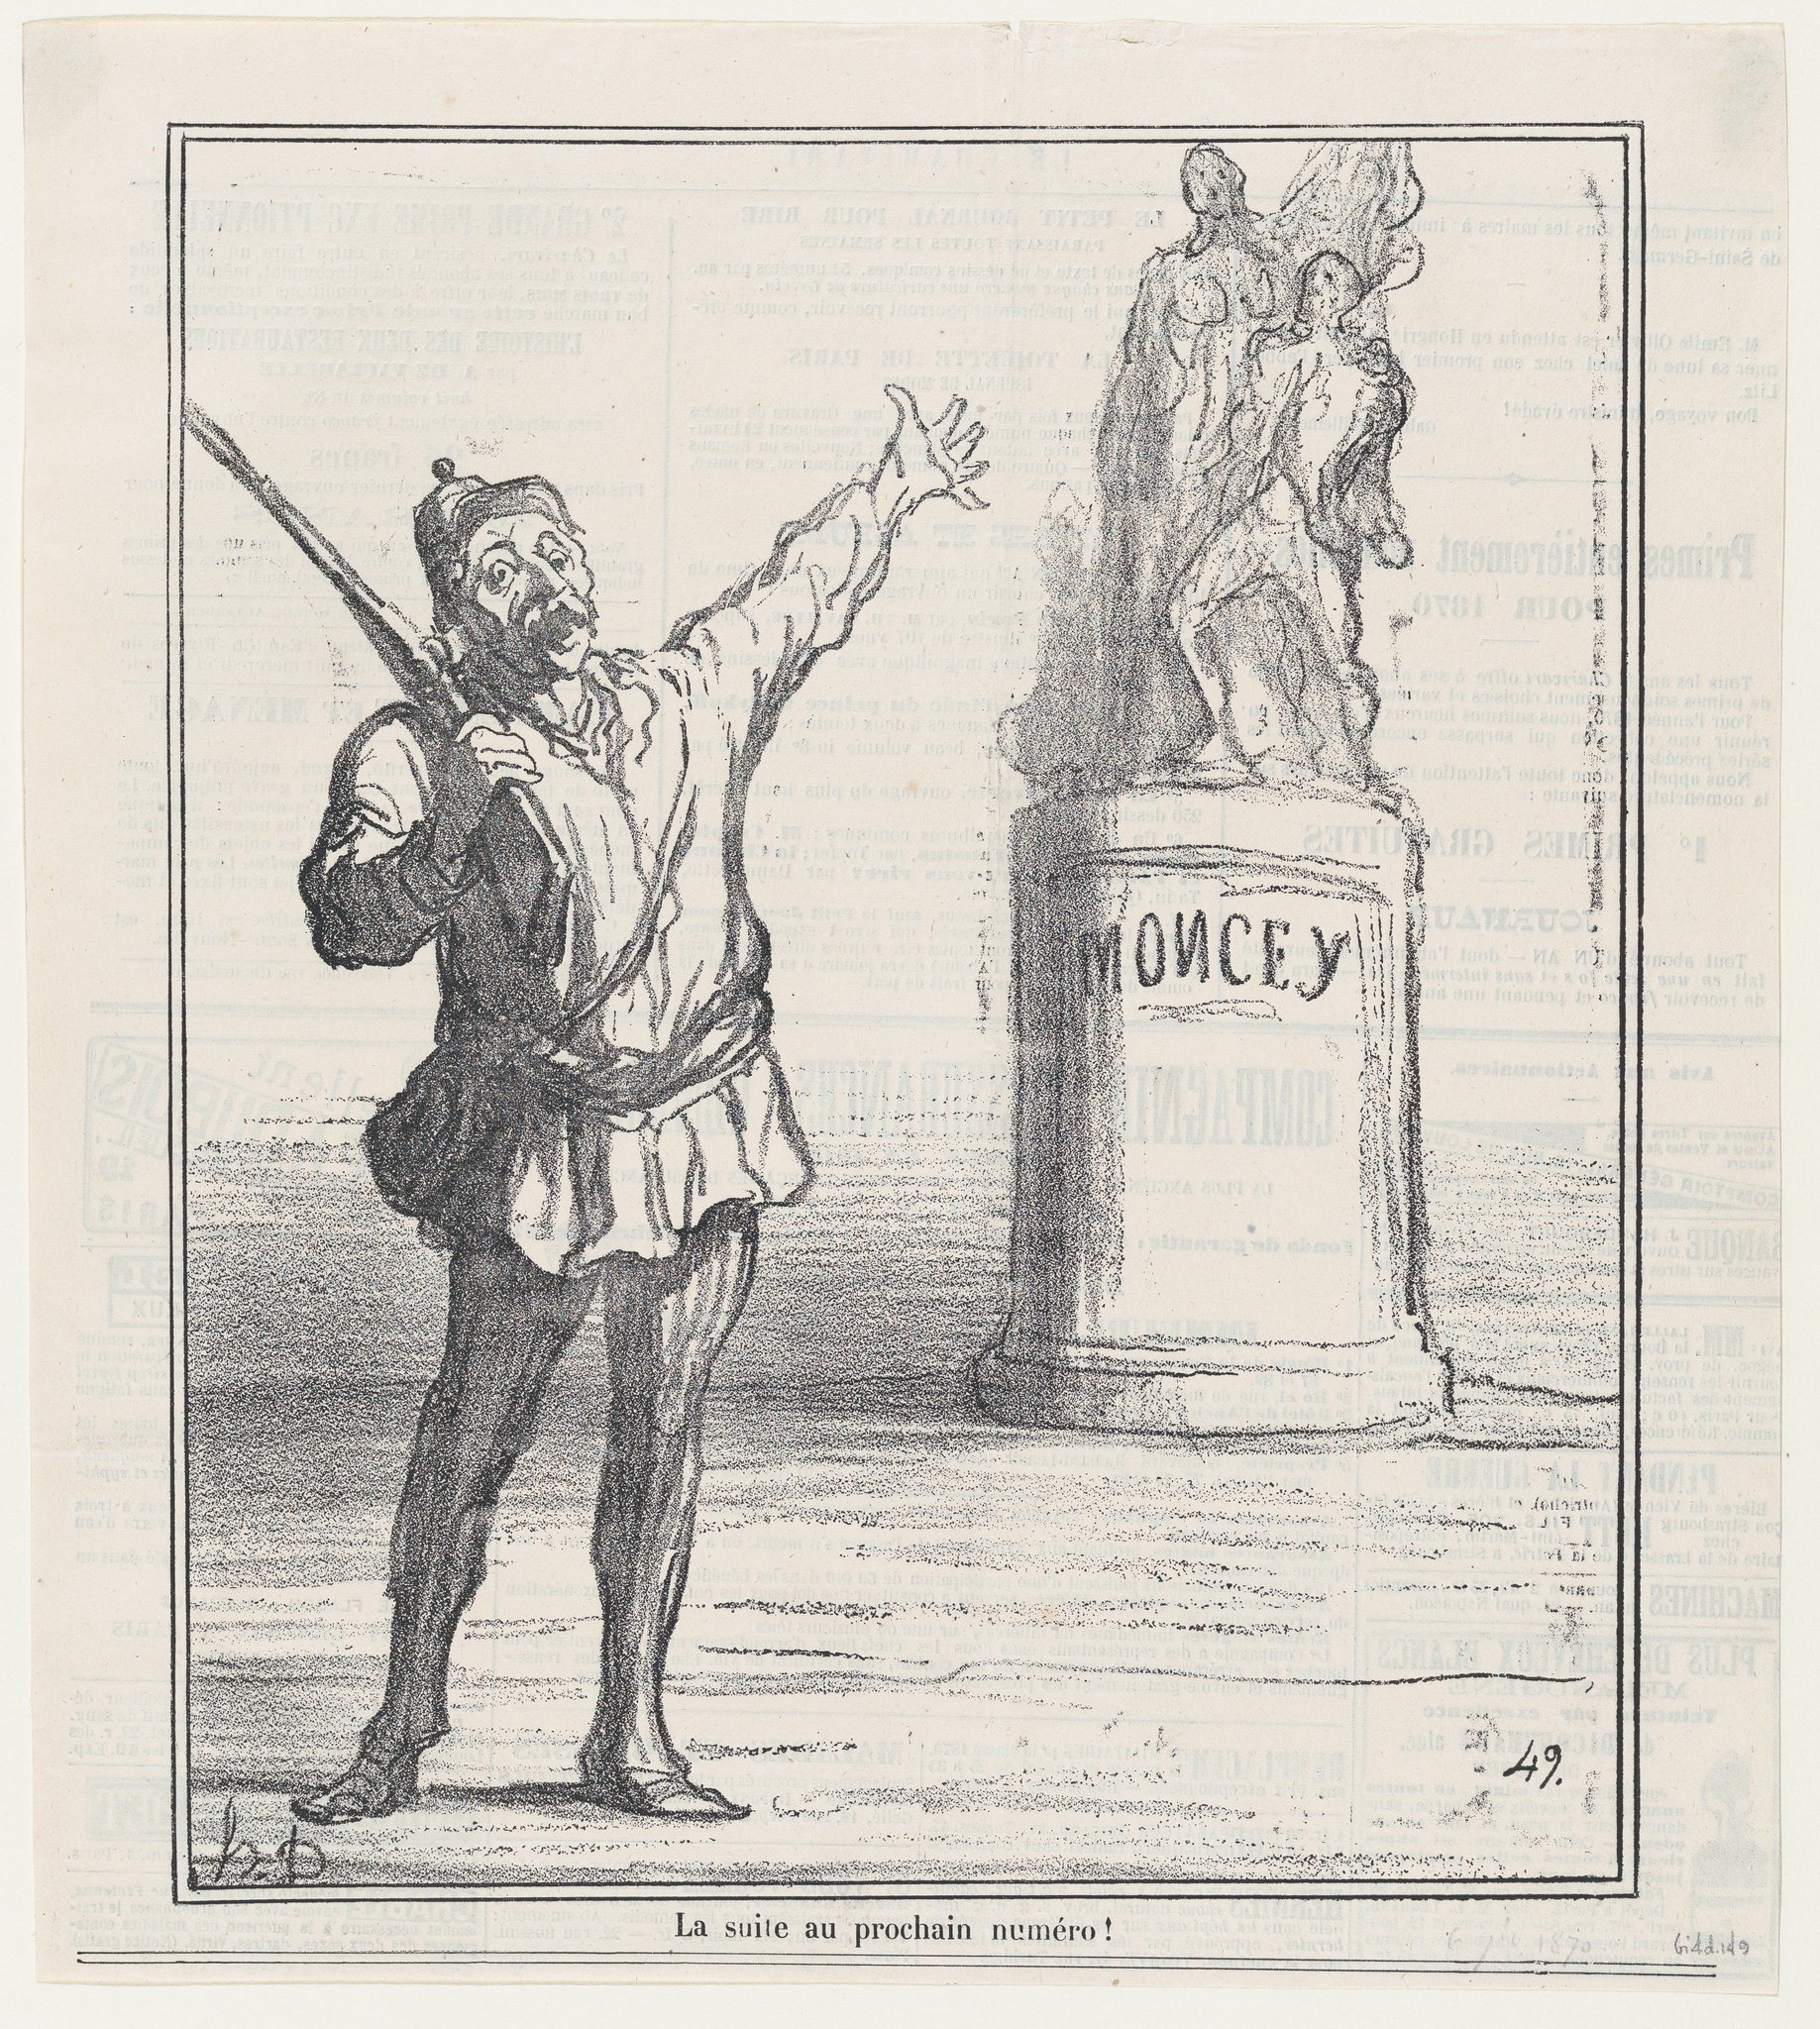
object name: print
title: To be followed in the next edition!, from 'News of the day,' published in Le Charivari, September 7, 1870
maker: honoré daumier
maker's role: artist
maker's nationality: french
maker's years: 1808-1879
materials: paper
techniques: lithograph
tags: men